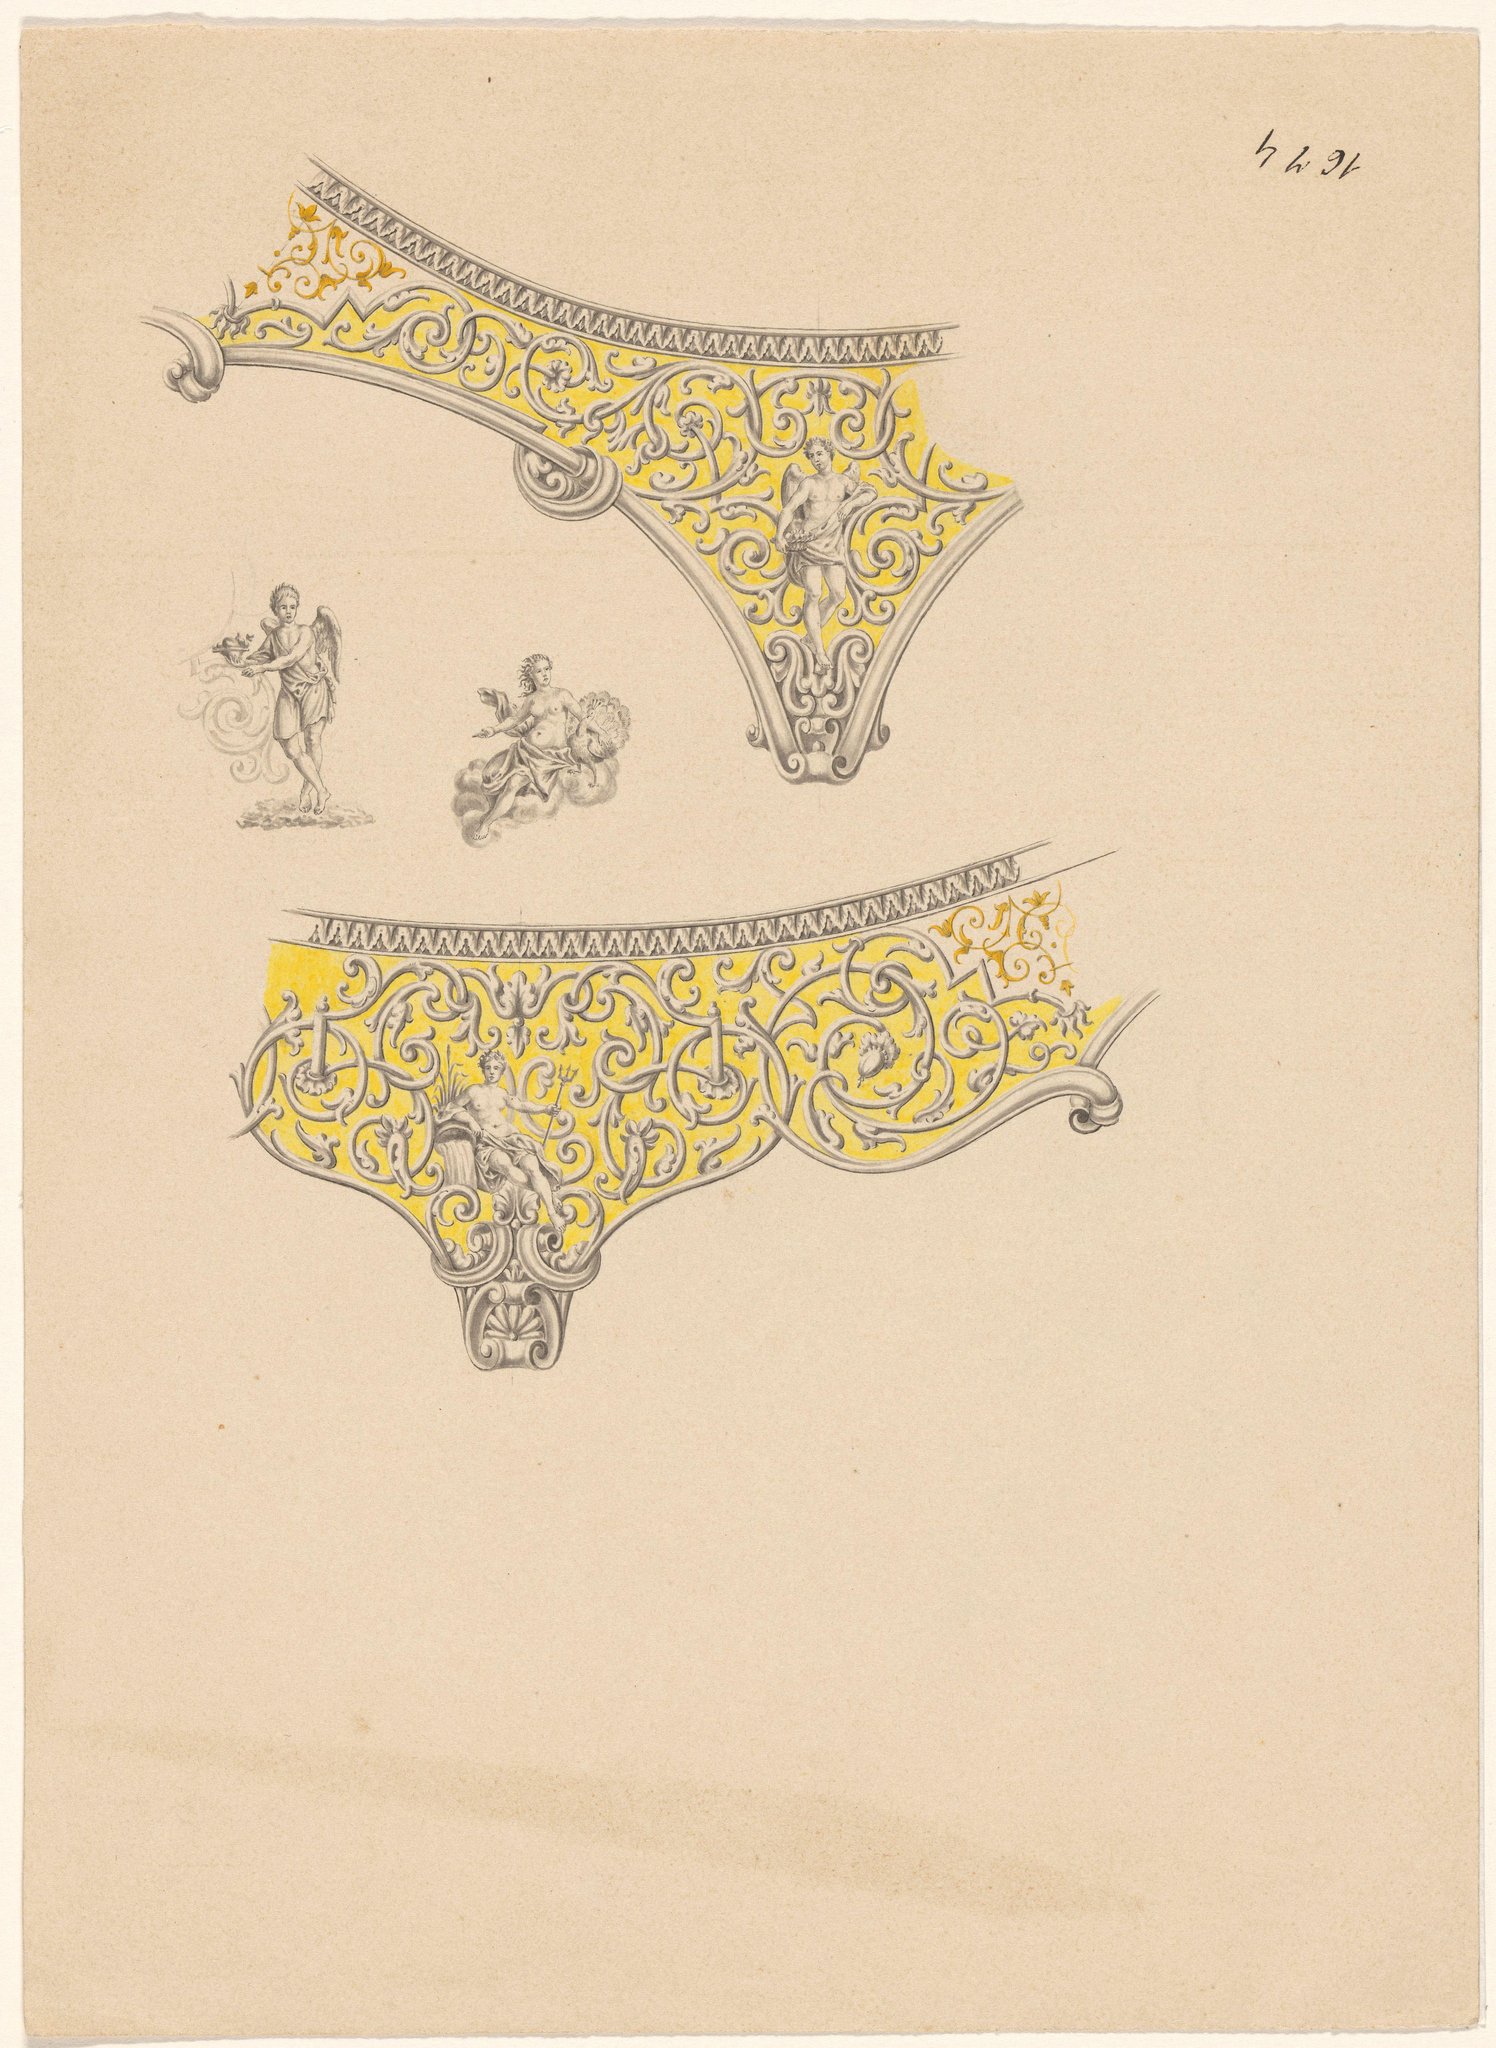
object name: design drawing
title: Gedamascineerd ijzeren rand, met Juno, Neptunus en twee geniën met vruchtenmanden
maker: eusebio zuloaga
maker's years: 1808-1898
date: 1850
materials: graphite, paper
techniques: brush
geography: eibar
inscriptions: number: ‘1674’, inscription: ‘Carpeta XVIII / No. 2.482’